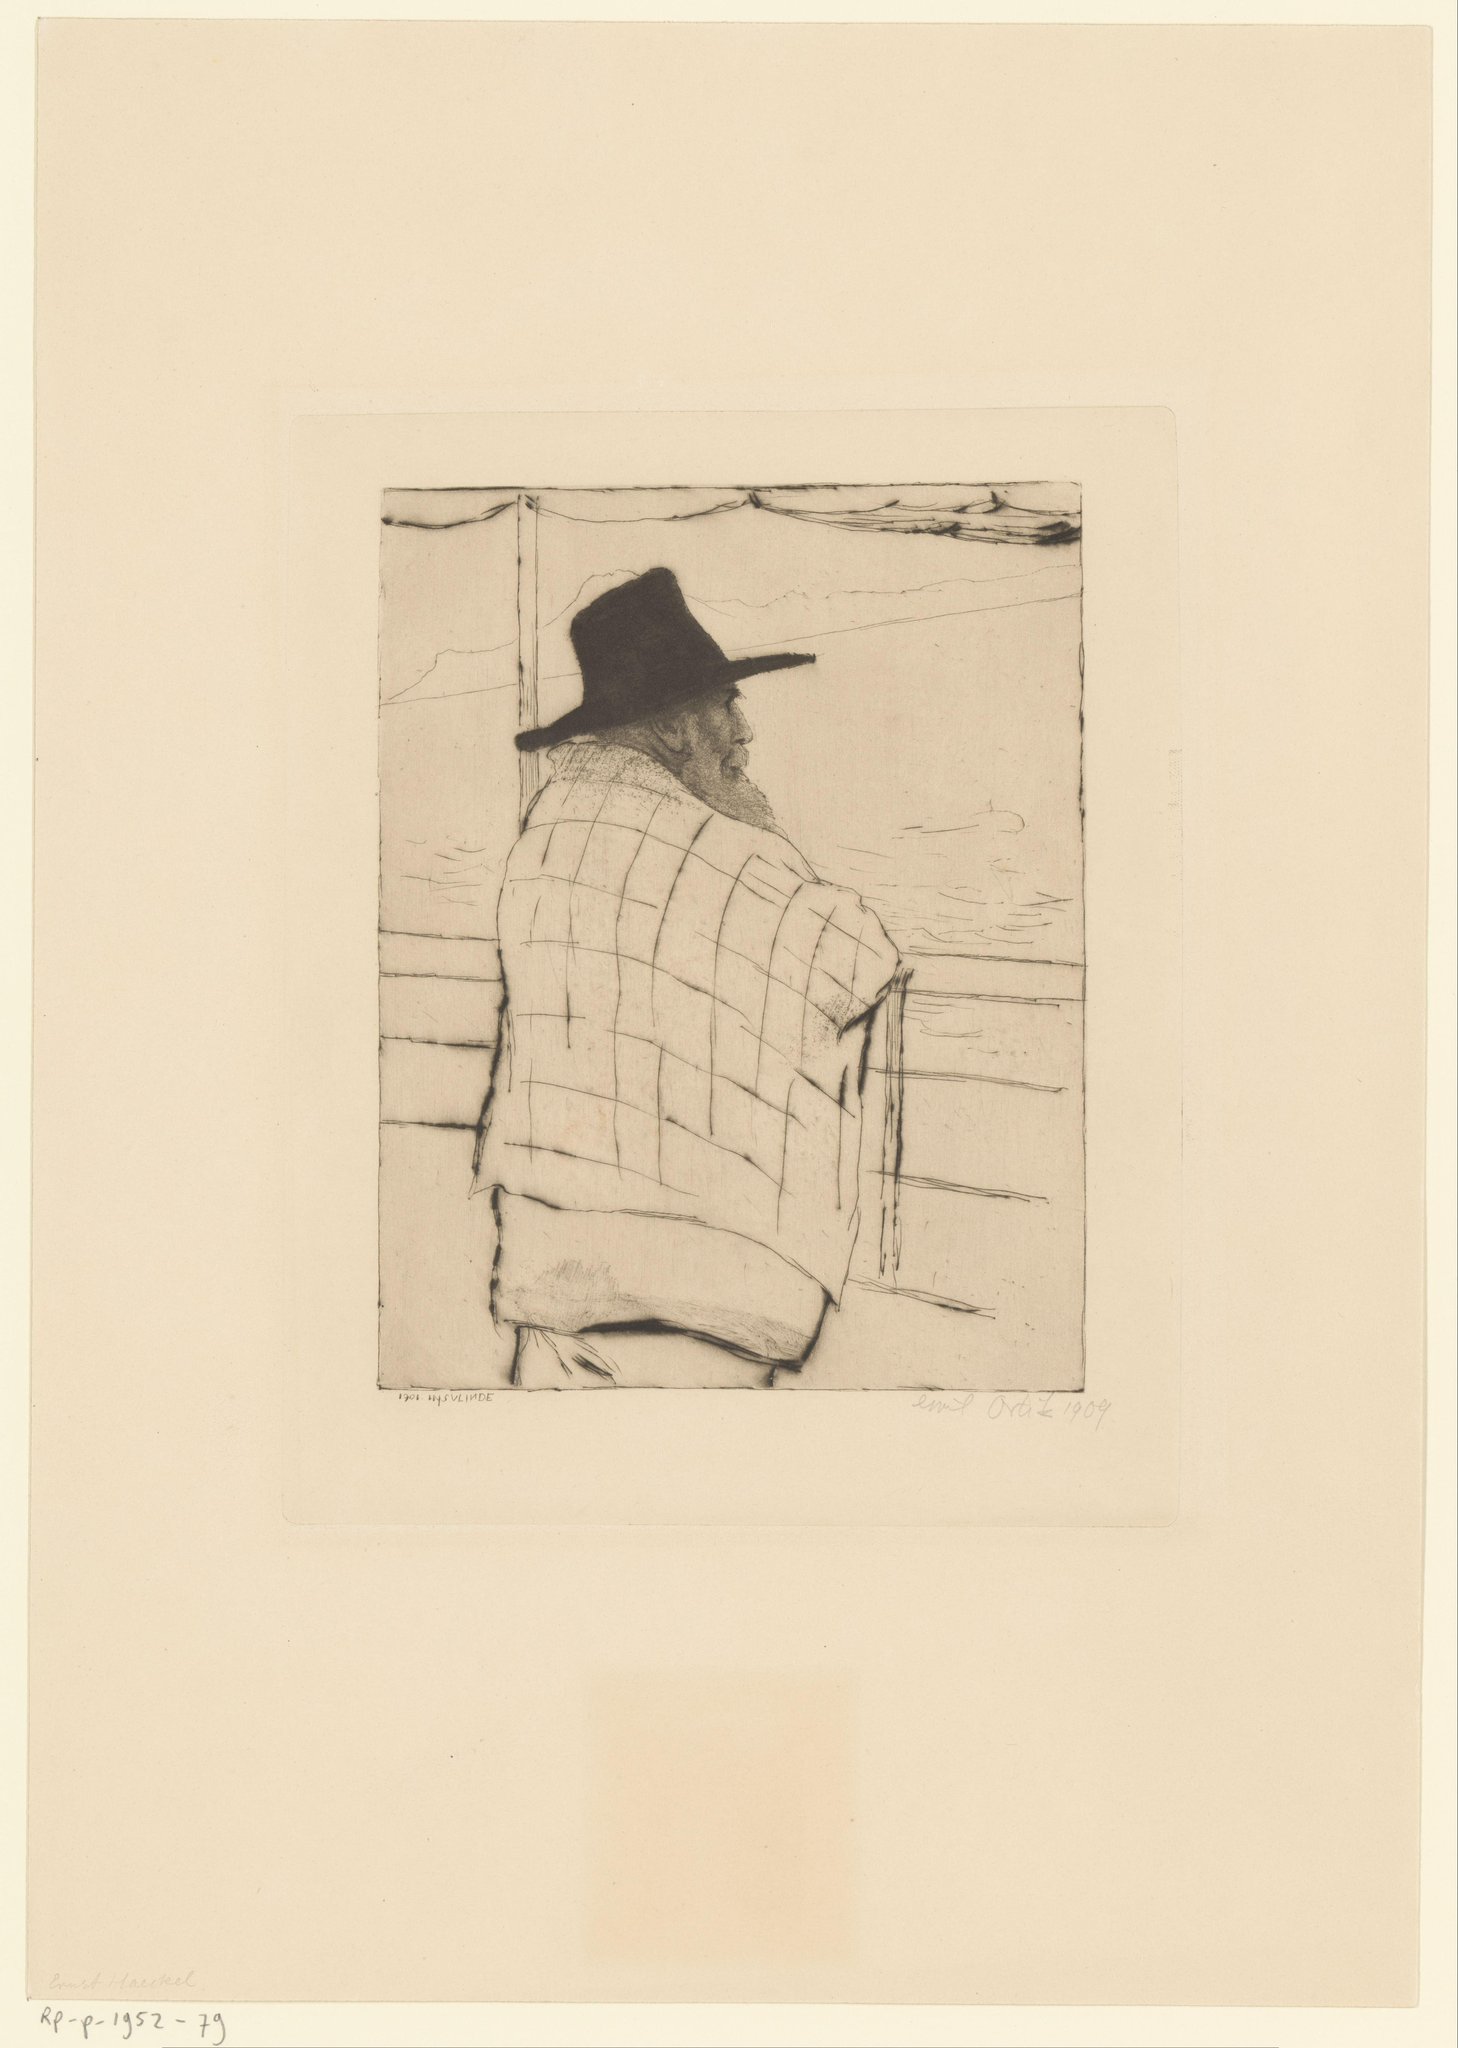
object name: print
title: Portret van Ernst Haeckel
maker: emil orlik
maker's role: painter, print maker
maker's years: 1870-1932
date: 1909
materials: paper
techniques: drypoint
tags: historical persons, indonesia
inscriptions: name: ‘Emil Orlik 1909’, collector's mark: Lugt 2228, collector's mark: Lugt 1914a